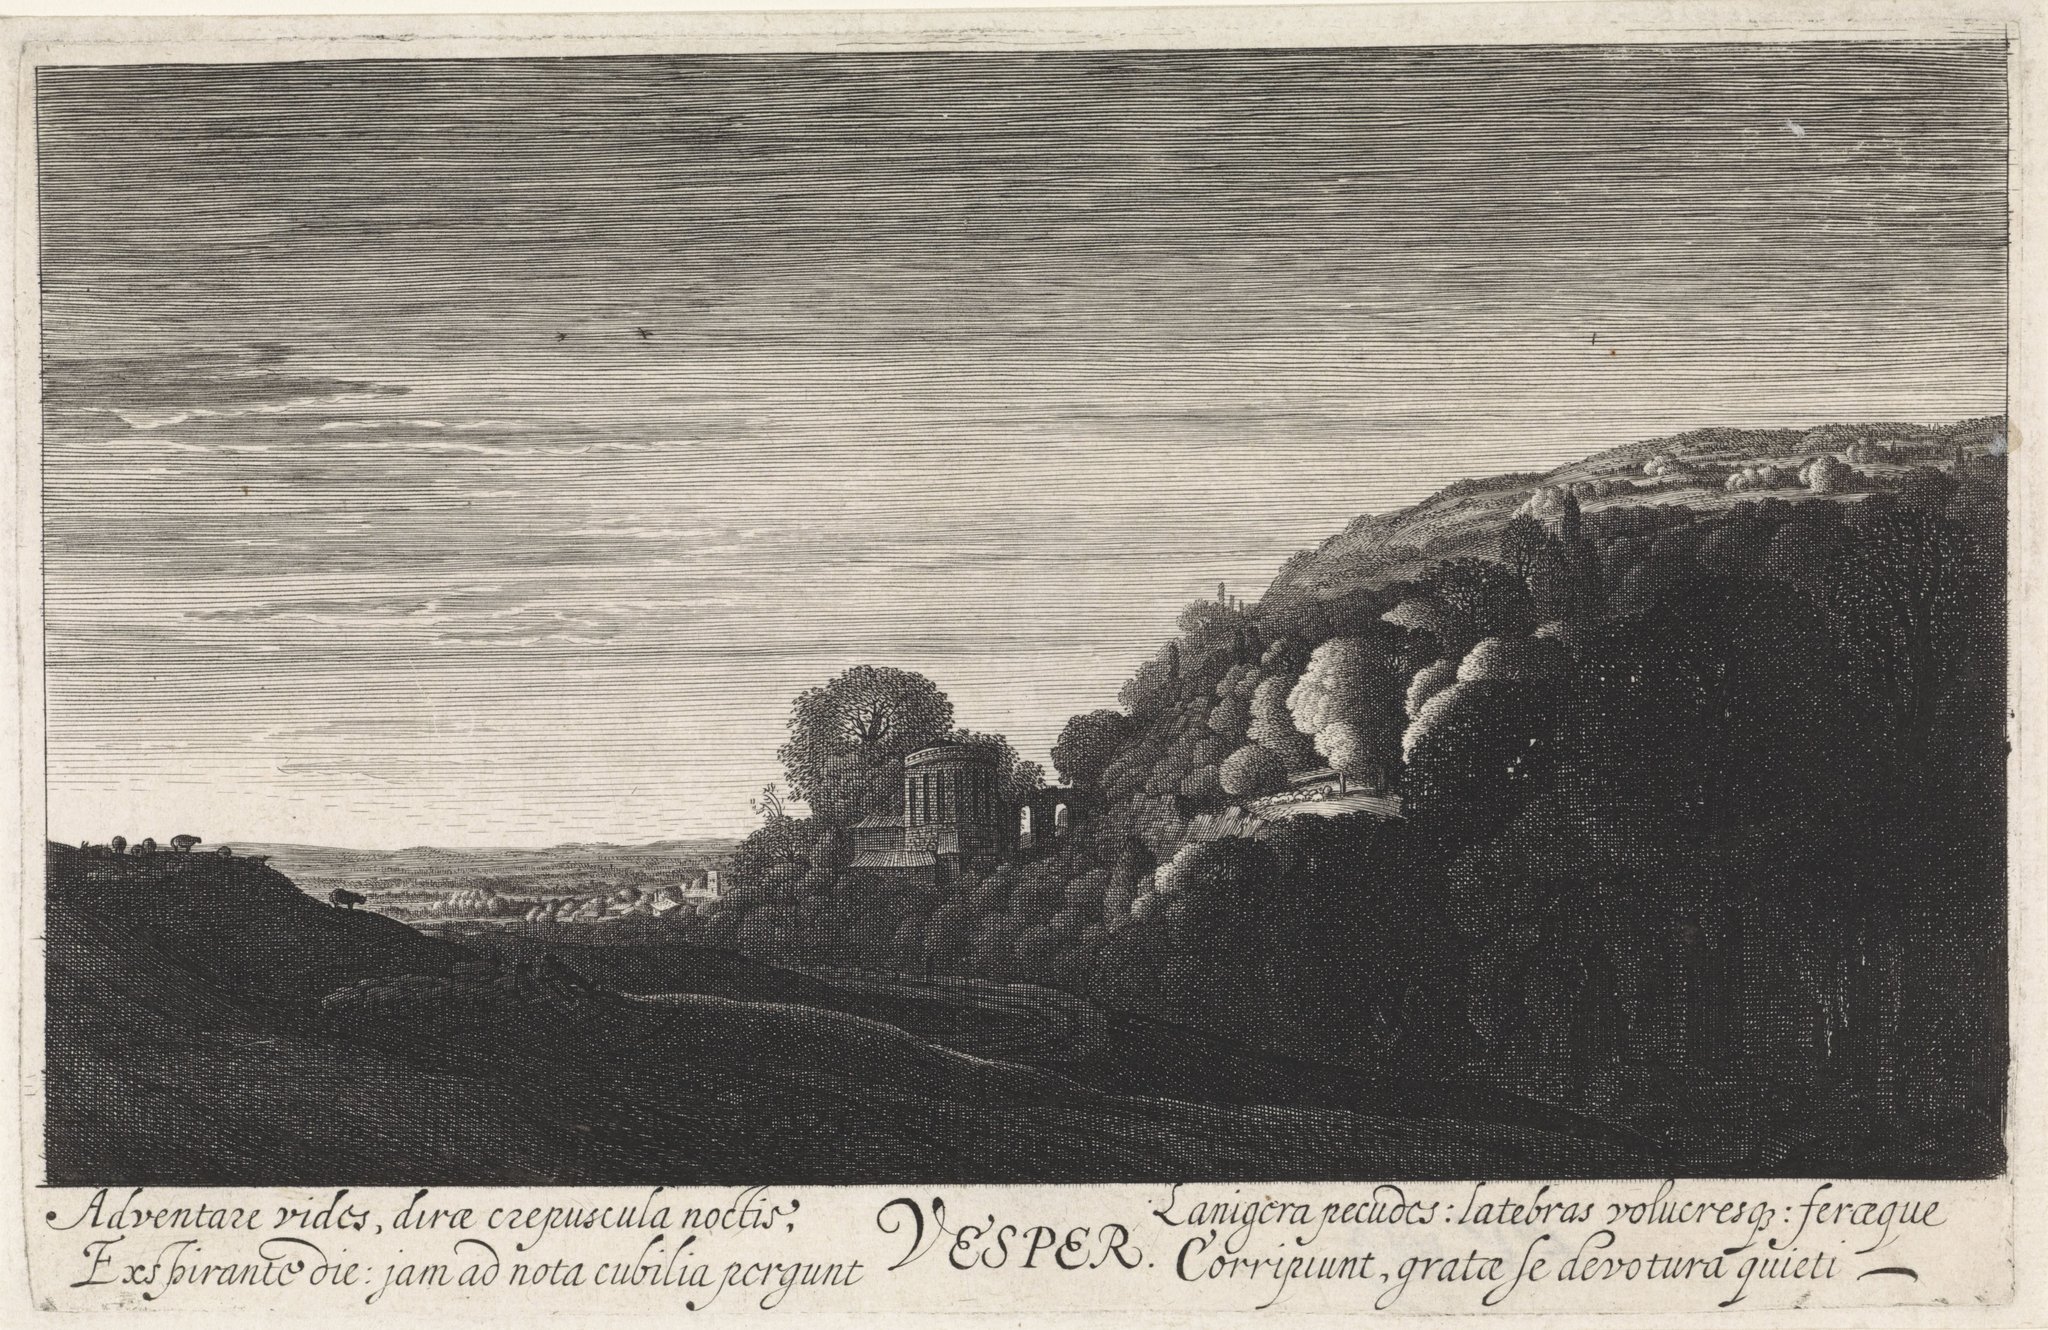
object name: print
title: De delen van de dag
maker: jan van de velde (ii)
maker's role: draughtsman, painter, print maker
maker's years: 1593-1641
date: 1603-1641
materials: paper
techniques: engraving, etching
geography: northern netherlands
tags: (high) hill, evening ~ landscape (sometimes titled 'vesper')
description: Gezicht op een Italianiserend heuvellandschap met in de schemer, voorstellende de avond. Prent uit een serie van vier.